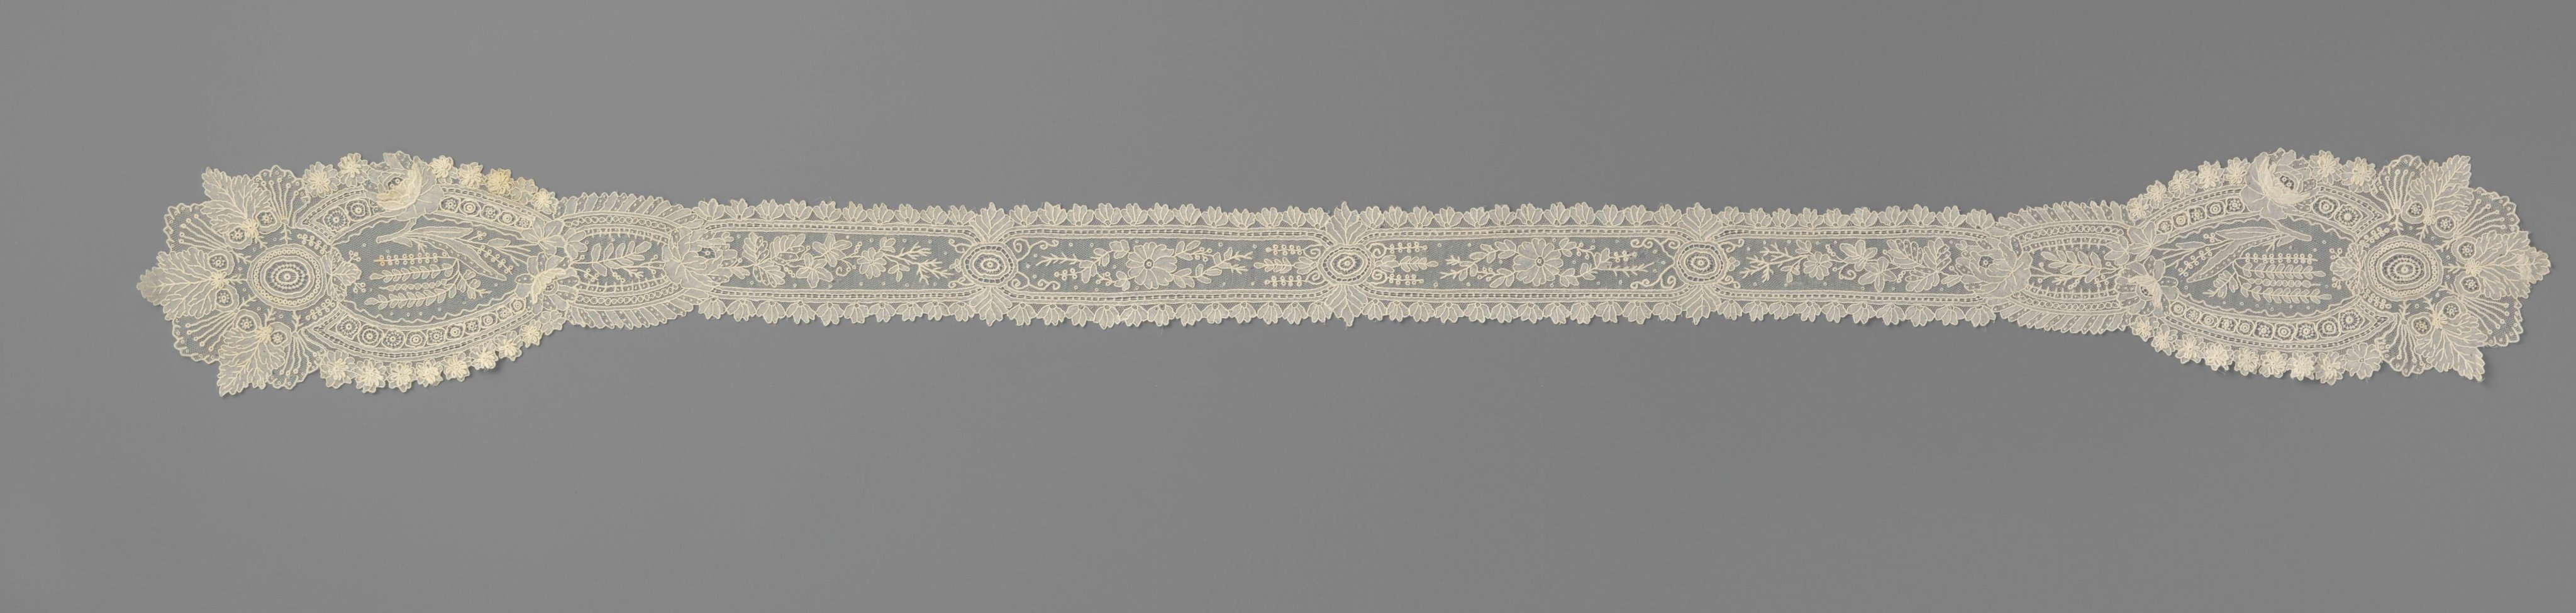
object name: neckcloth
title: Dasje van naaldkant met gouden regen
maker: Anonymous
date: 1870-1890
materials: linen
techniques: needle lace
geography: brussels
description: Een zeer smalle gerekte schakelband van parellijst en klokjes verloopt in ingesnoerde, verbrede, knopvormige uiteinden, met een rand van verdubbelde rozetjes. In de knop ontspringt een lange rozetak en een hangende goudenregentros. Aan de toppen een krans van wingerdbladeren. Point de gaze de Bruxelles.